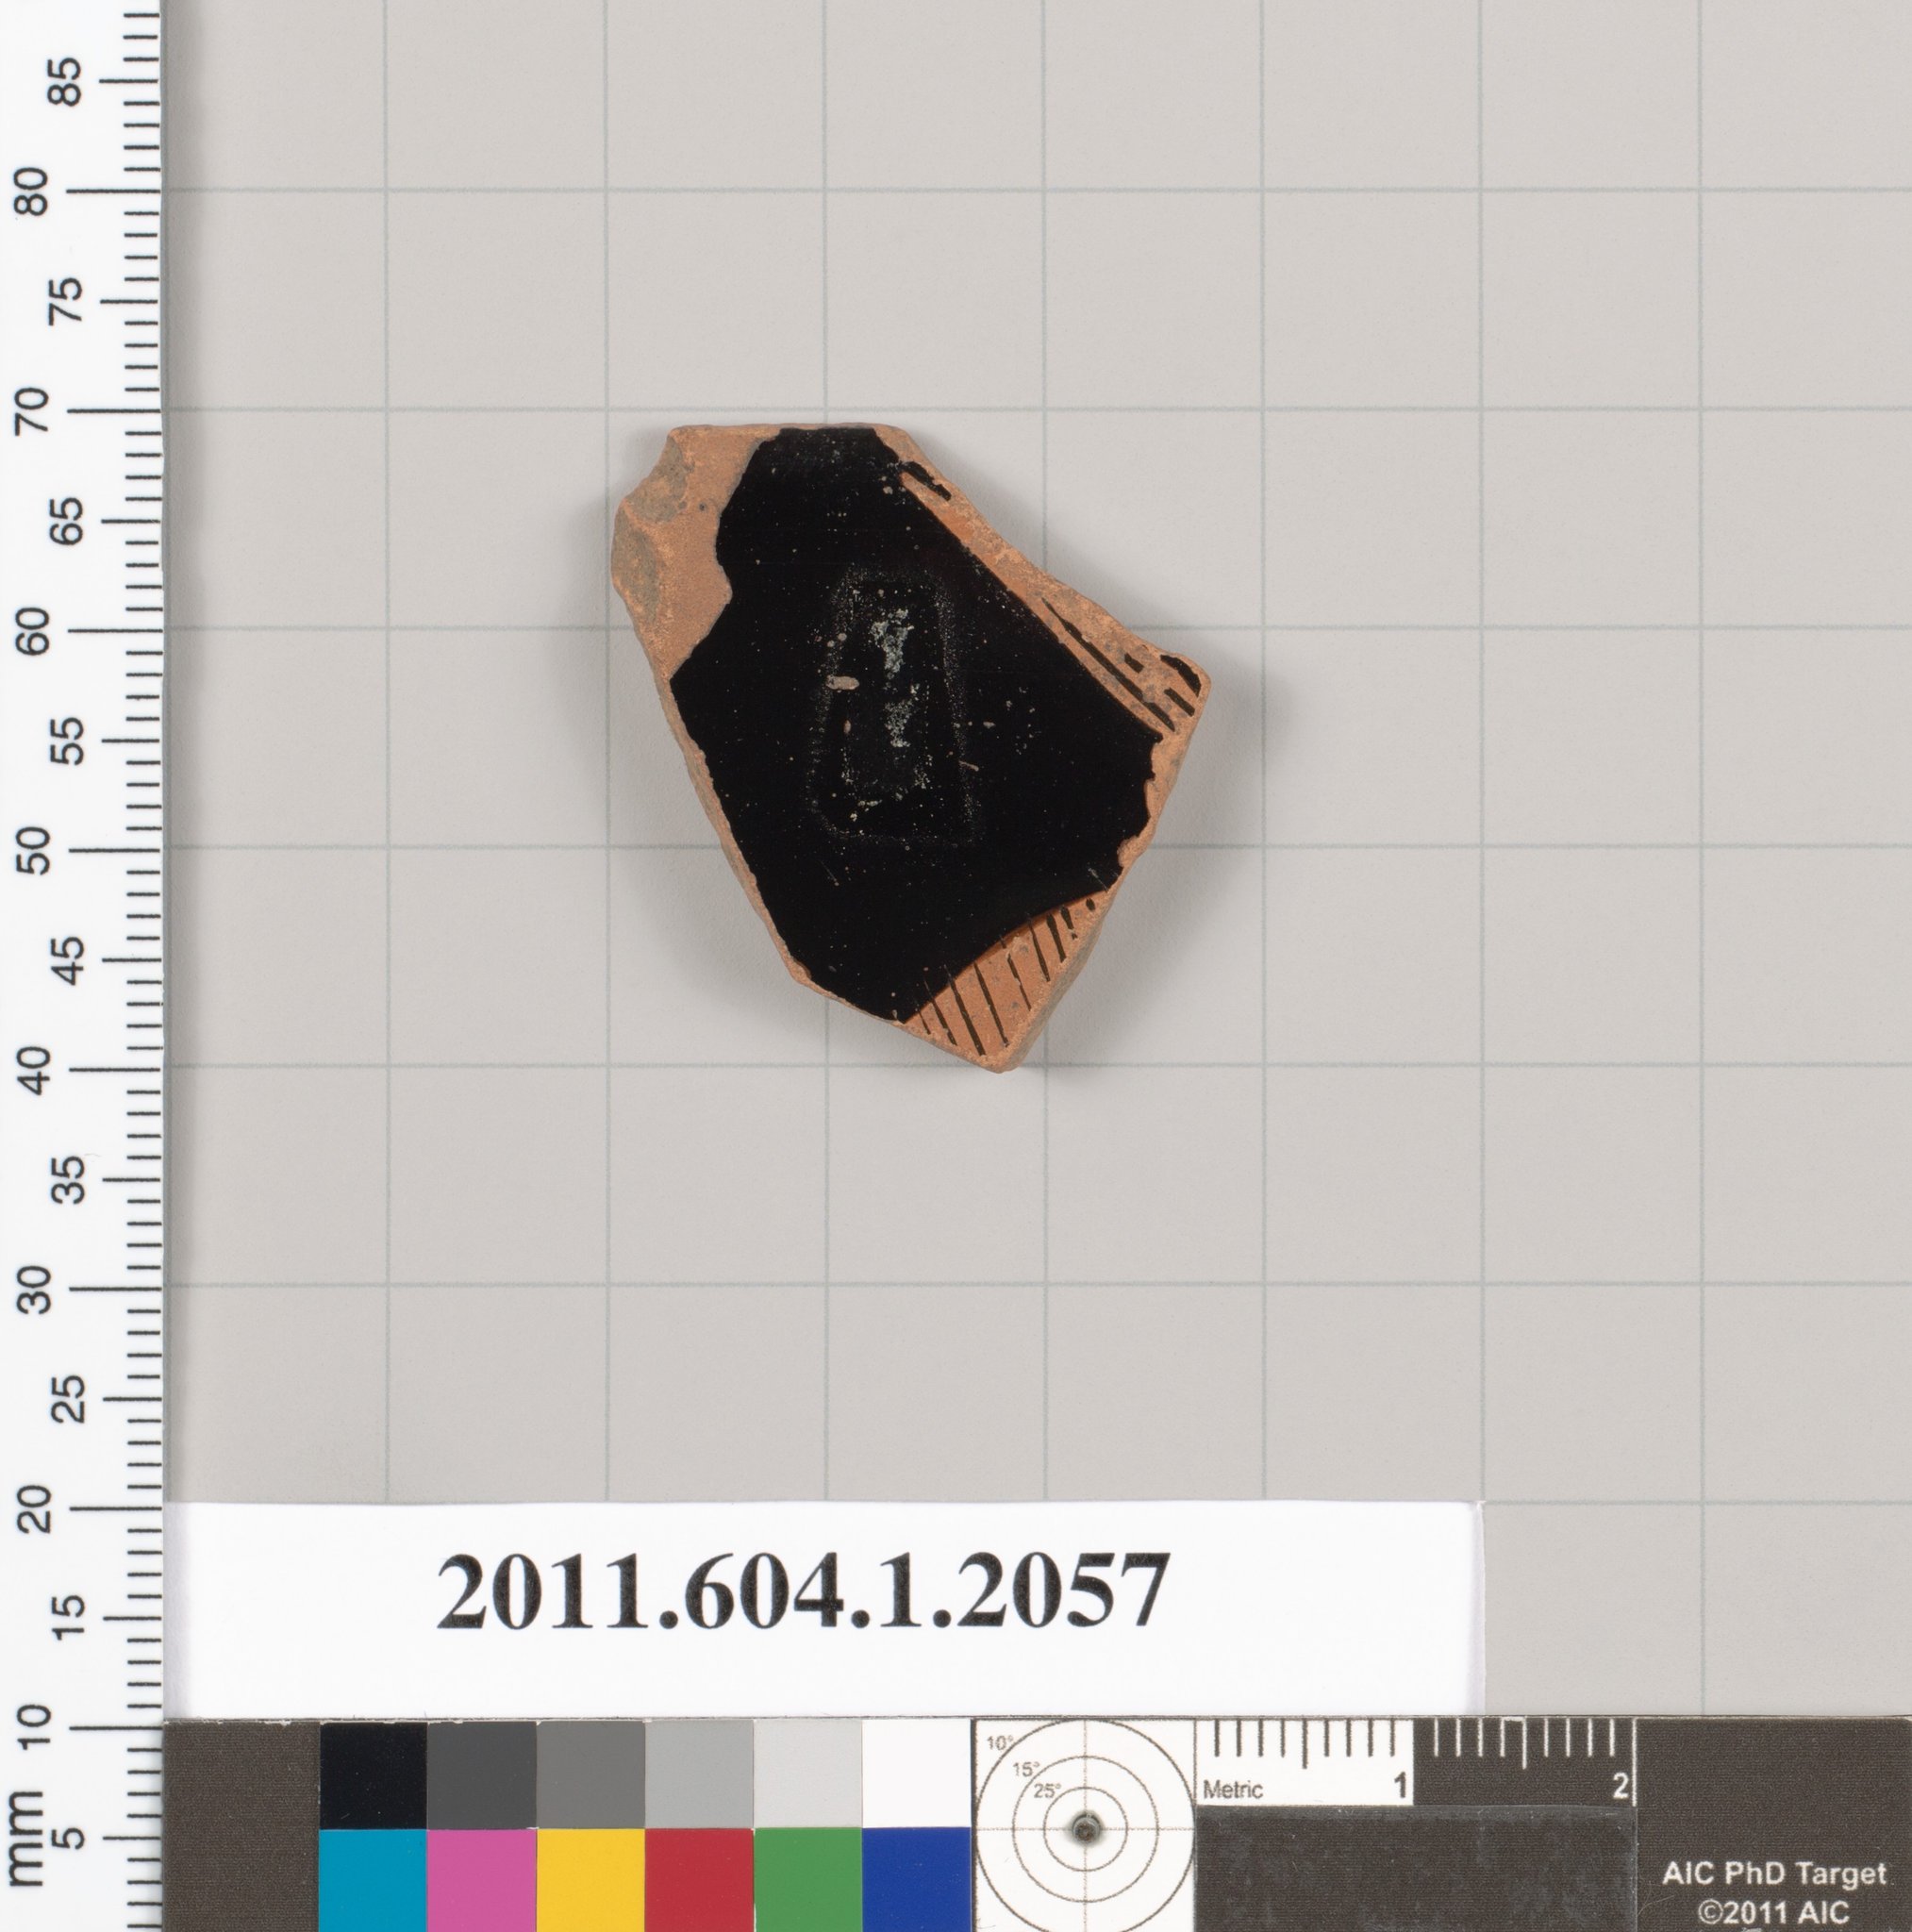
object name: kylix fragment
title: Terracotta rim fragment of a kylix (drinking cup)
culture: greek, attic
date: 475-451 BCE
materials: terracotta